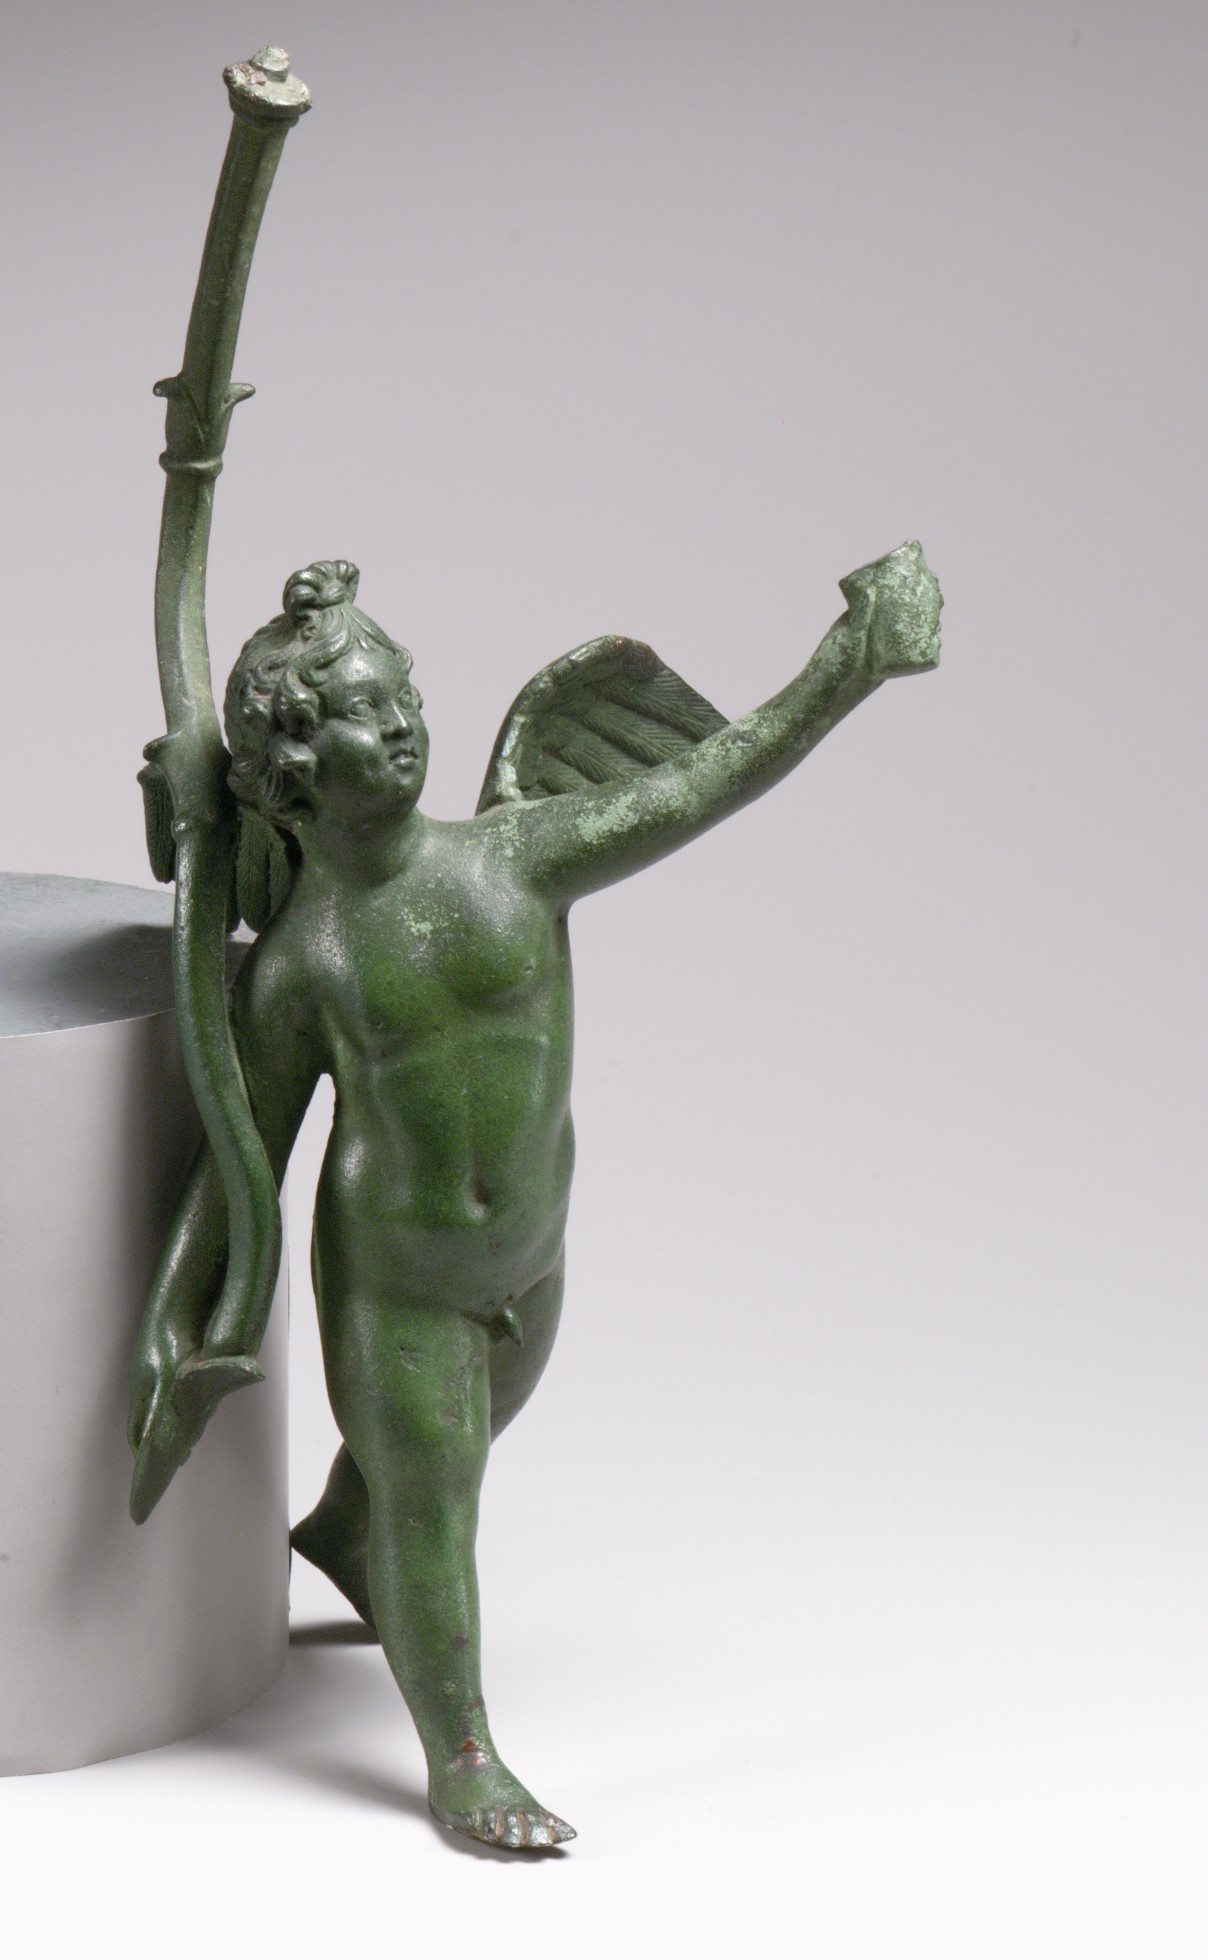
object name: statuette of eros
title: Bronze statuette of Eros running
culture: roman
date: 1-200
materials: bronze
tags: eros